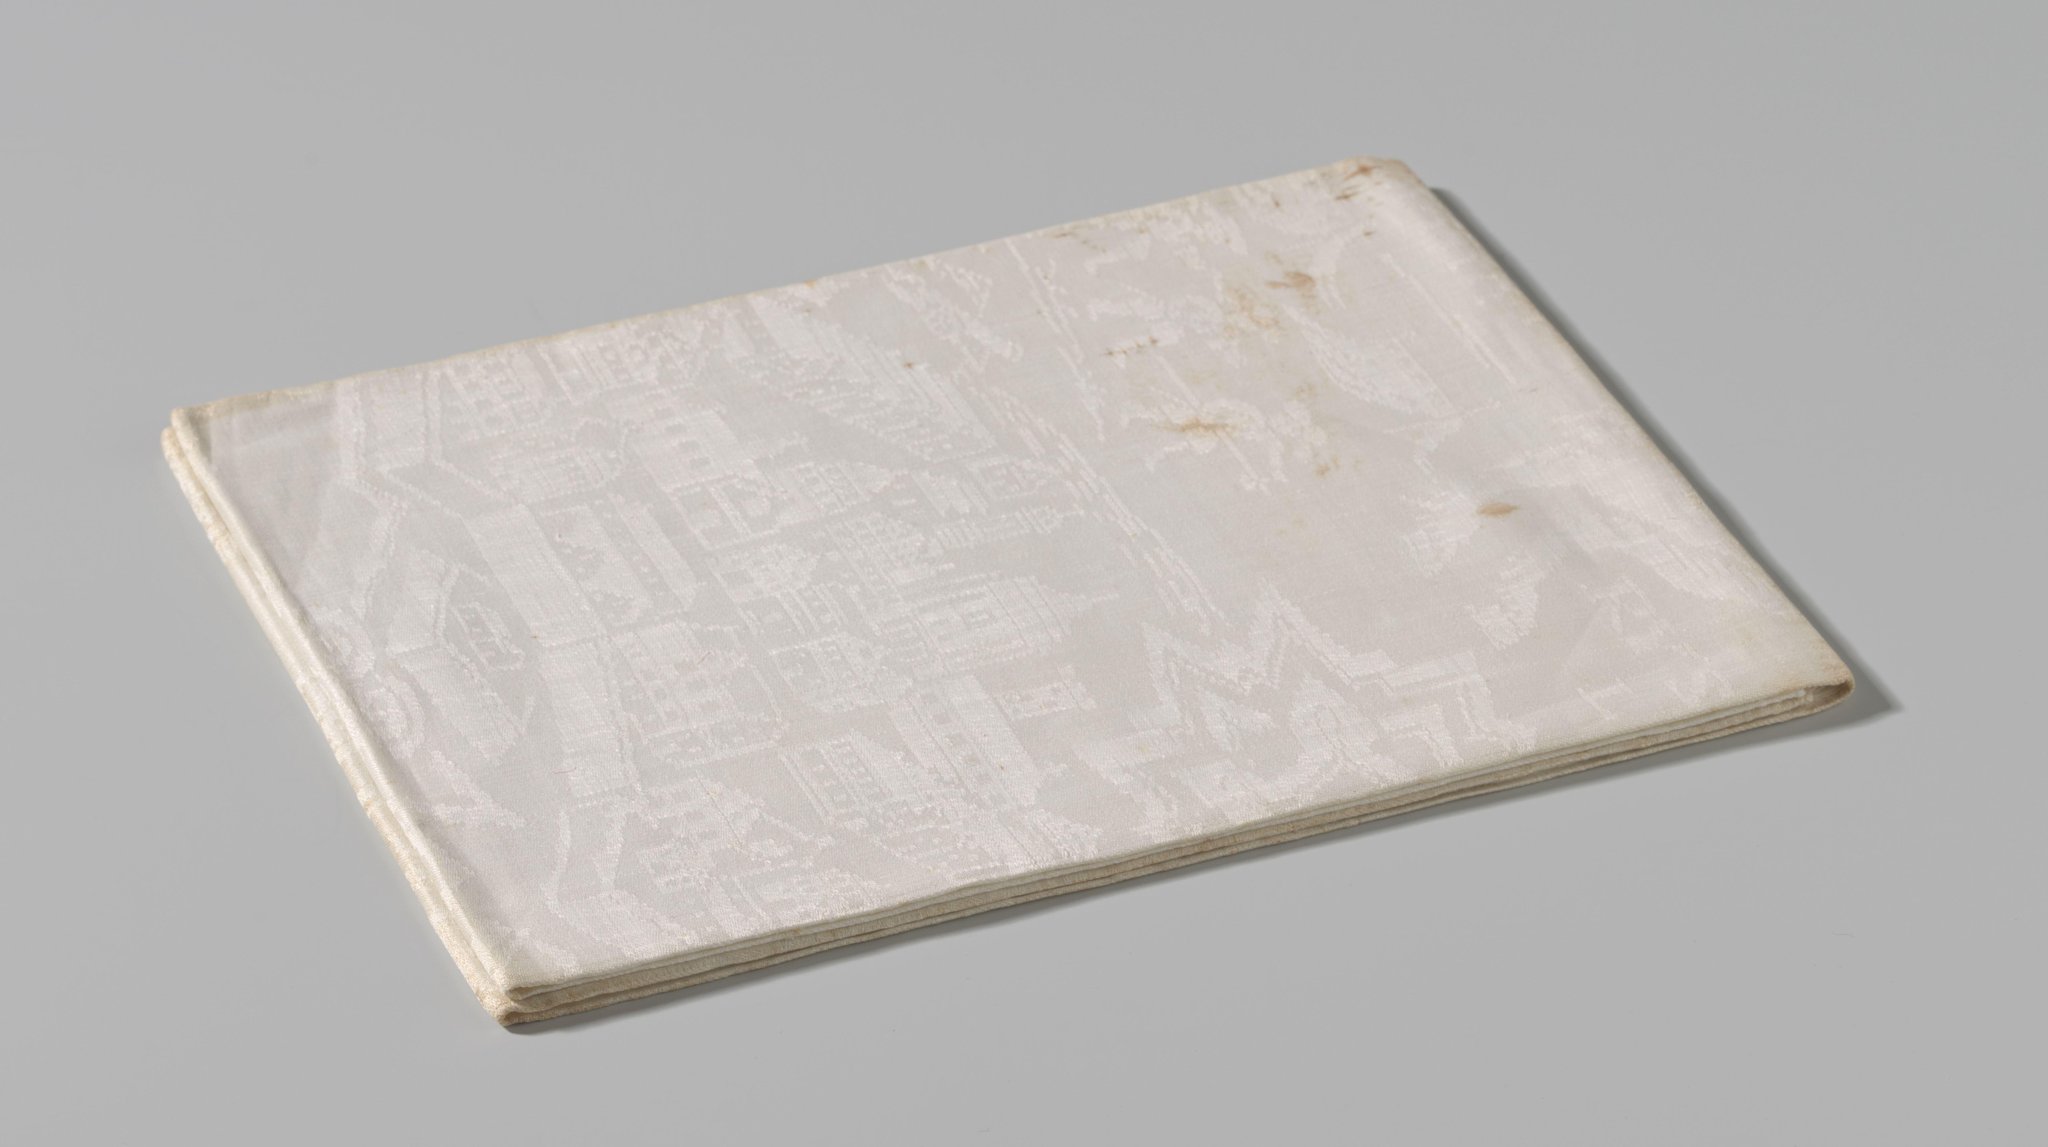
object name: napkin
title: Servet van linnendamast met de verovering van Lille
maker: Anonymous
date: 1709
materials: linen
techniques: damask, weave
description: Servet van linnendamast met de verovering van Lille